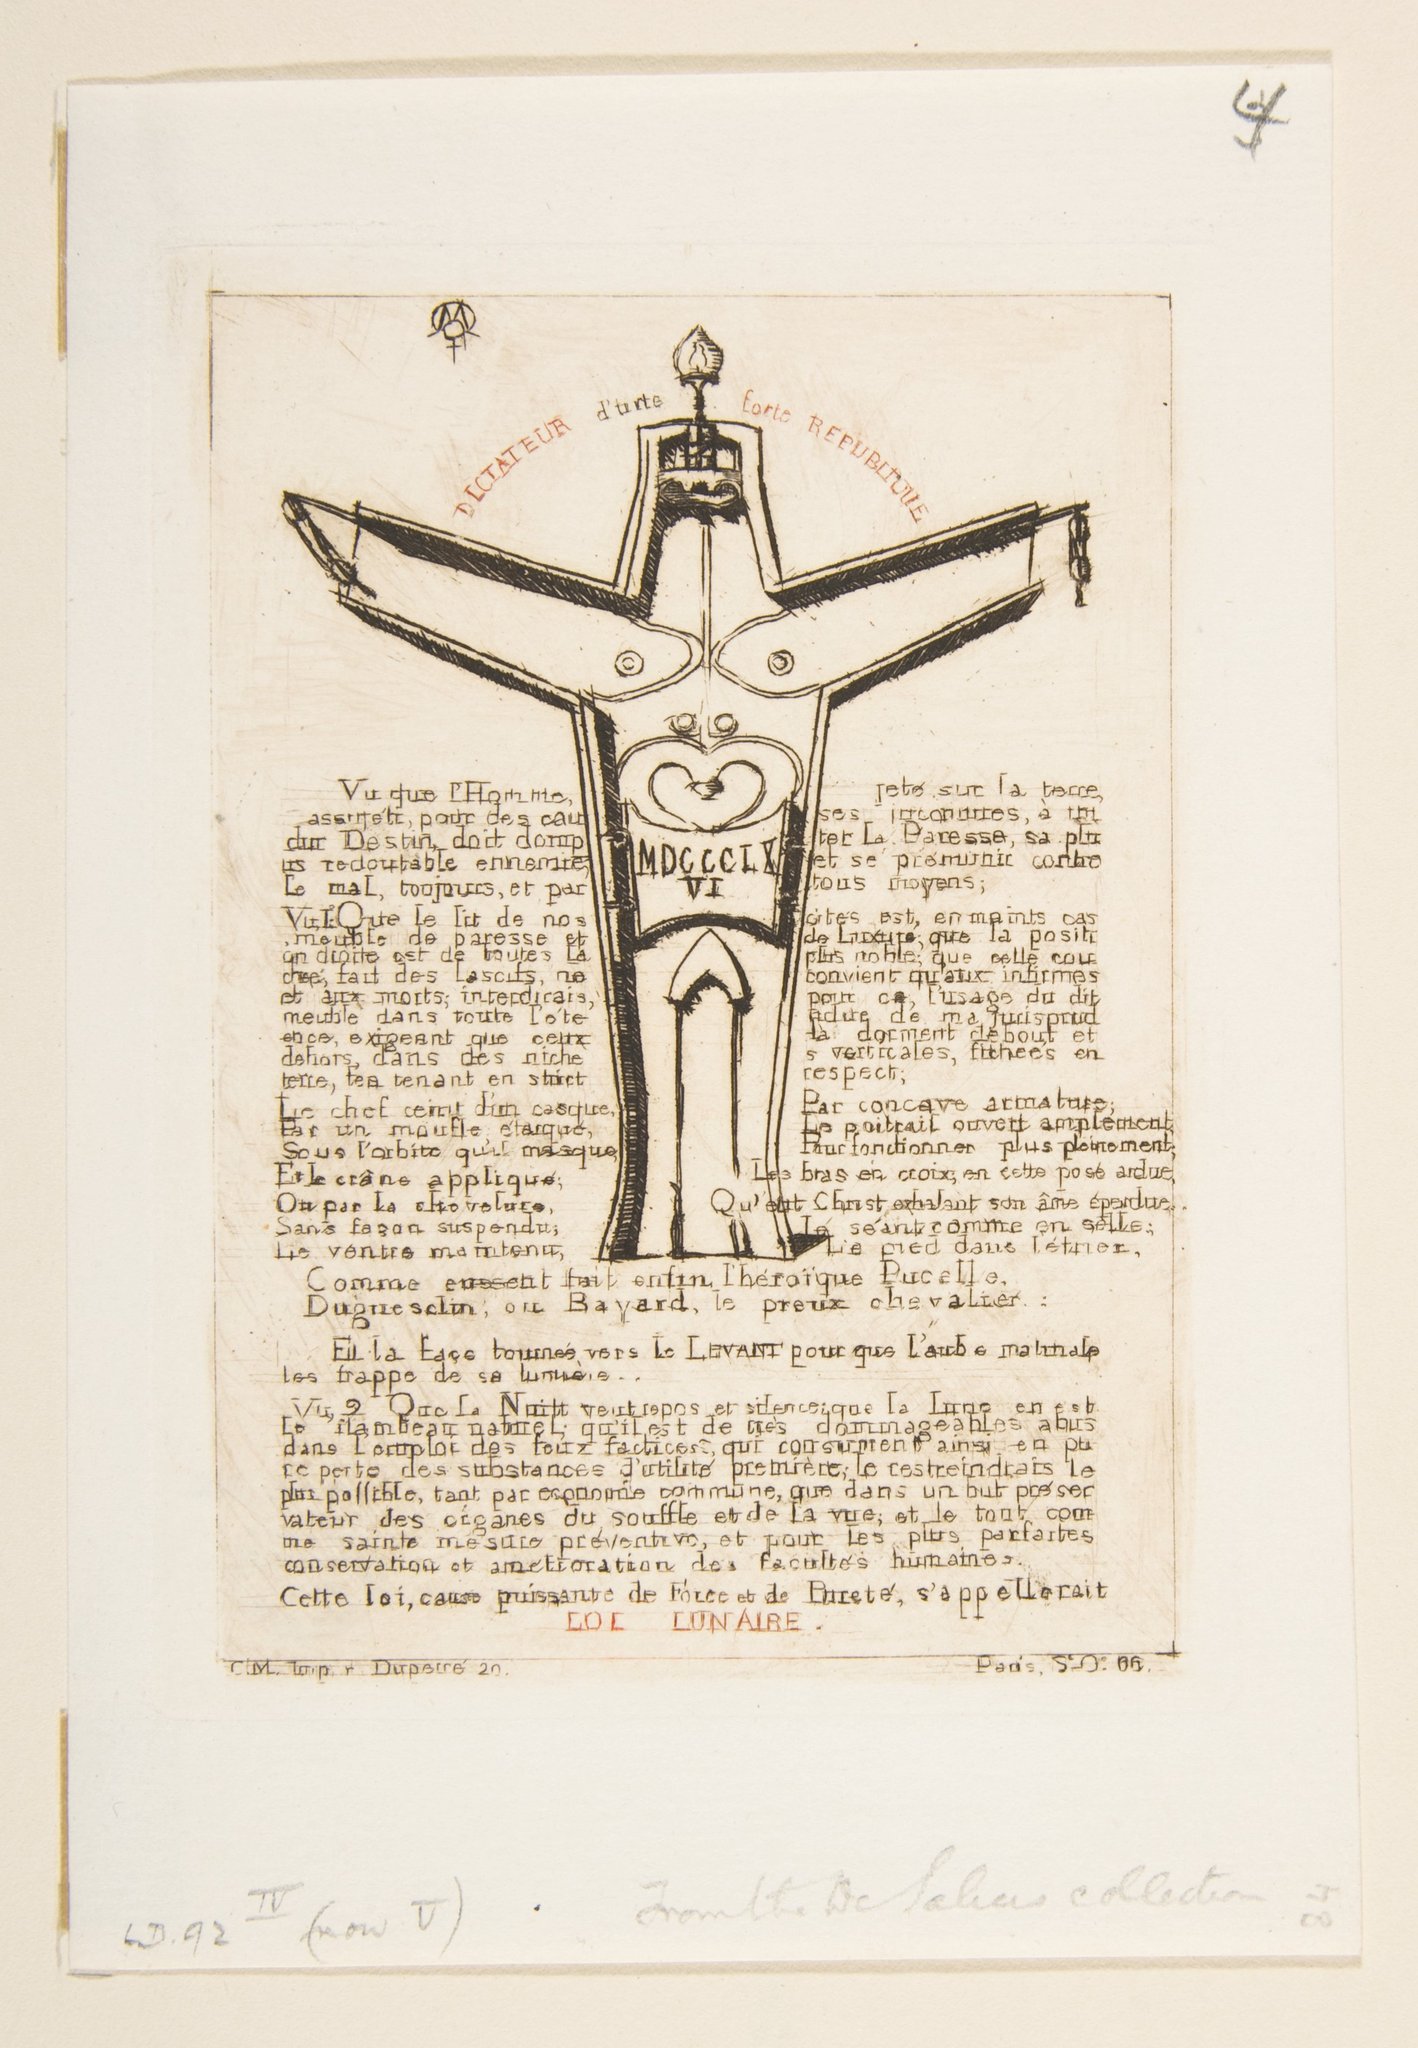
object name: print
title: Lunar Law, No. 2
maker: charles meryon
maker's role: artist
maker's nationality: french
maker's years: 1821-1868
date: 1866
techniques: etching